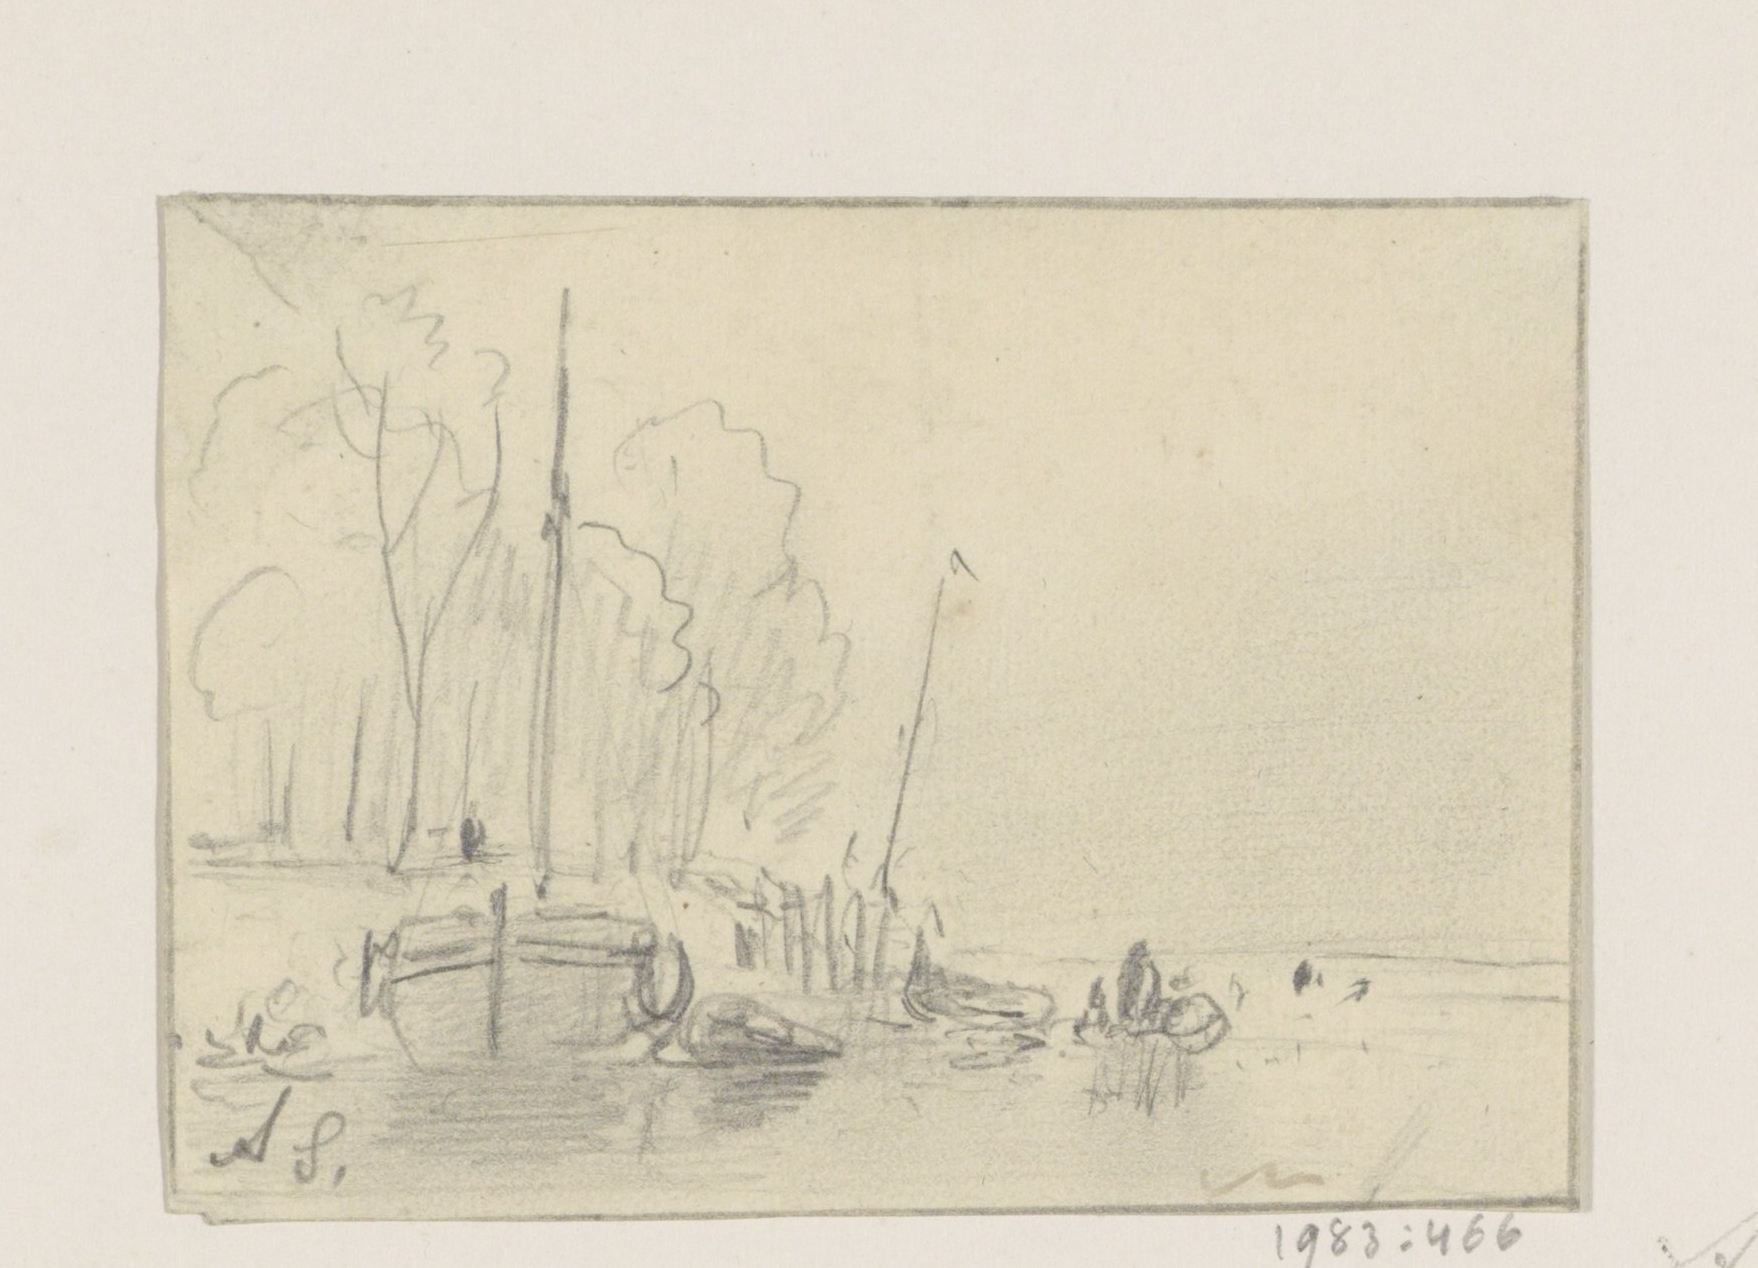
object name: drawing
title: Zeilboten aan een waterkant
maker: andreas schelfhout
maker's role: draughtsman, painter, print maker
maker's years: 1787-1870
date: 1797-1870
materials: paper, pencil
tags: sailing-ship, sailing-boat, river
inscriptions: collector's mark: Lugt 731a, signature: ‘A S.’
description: Aangemeerde zeilboten aan een waterkant waar bomen groeien. Tekening maakt deel uit van een album.